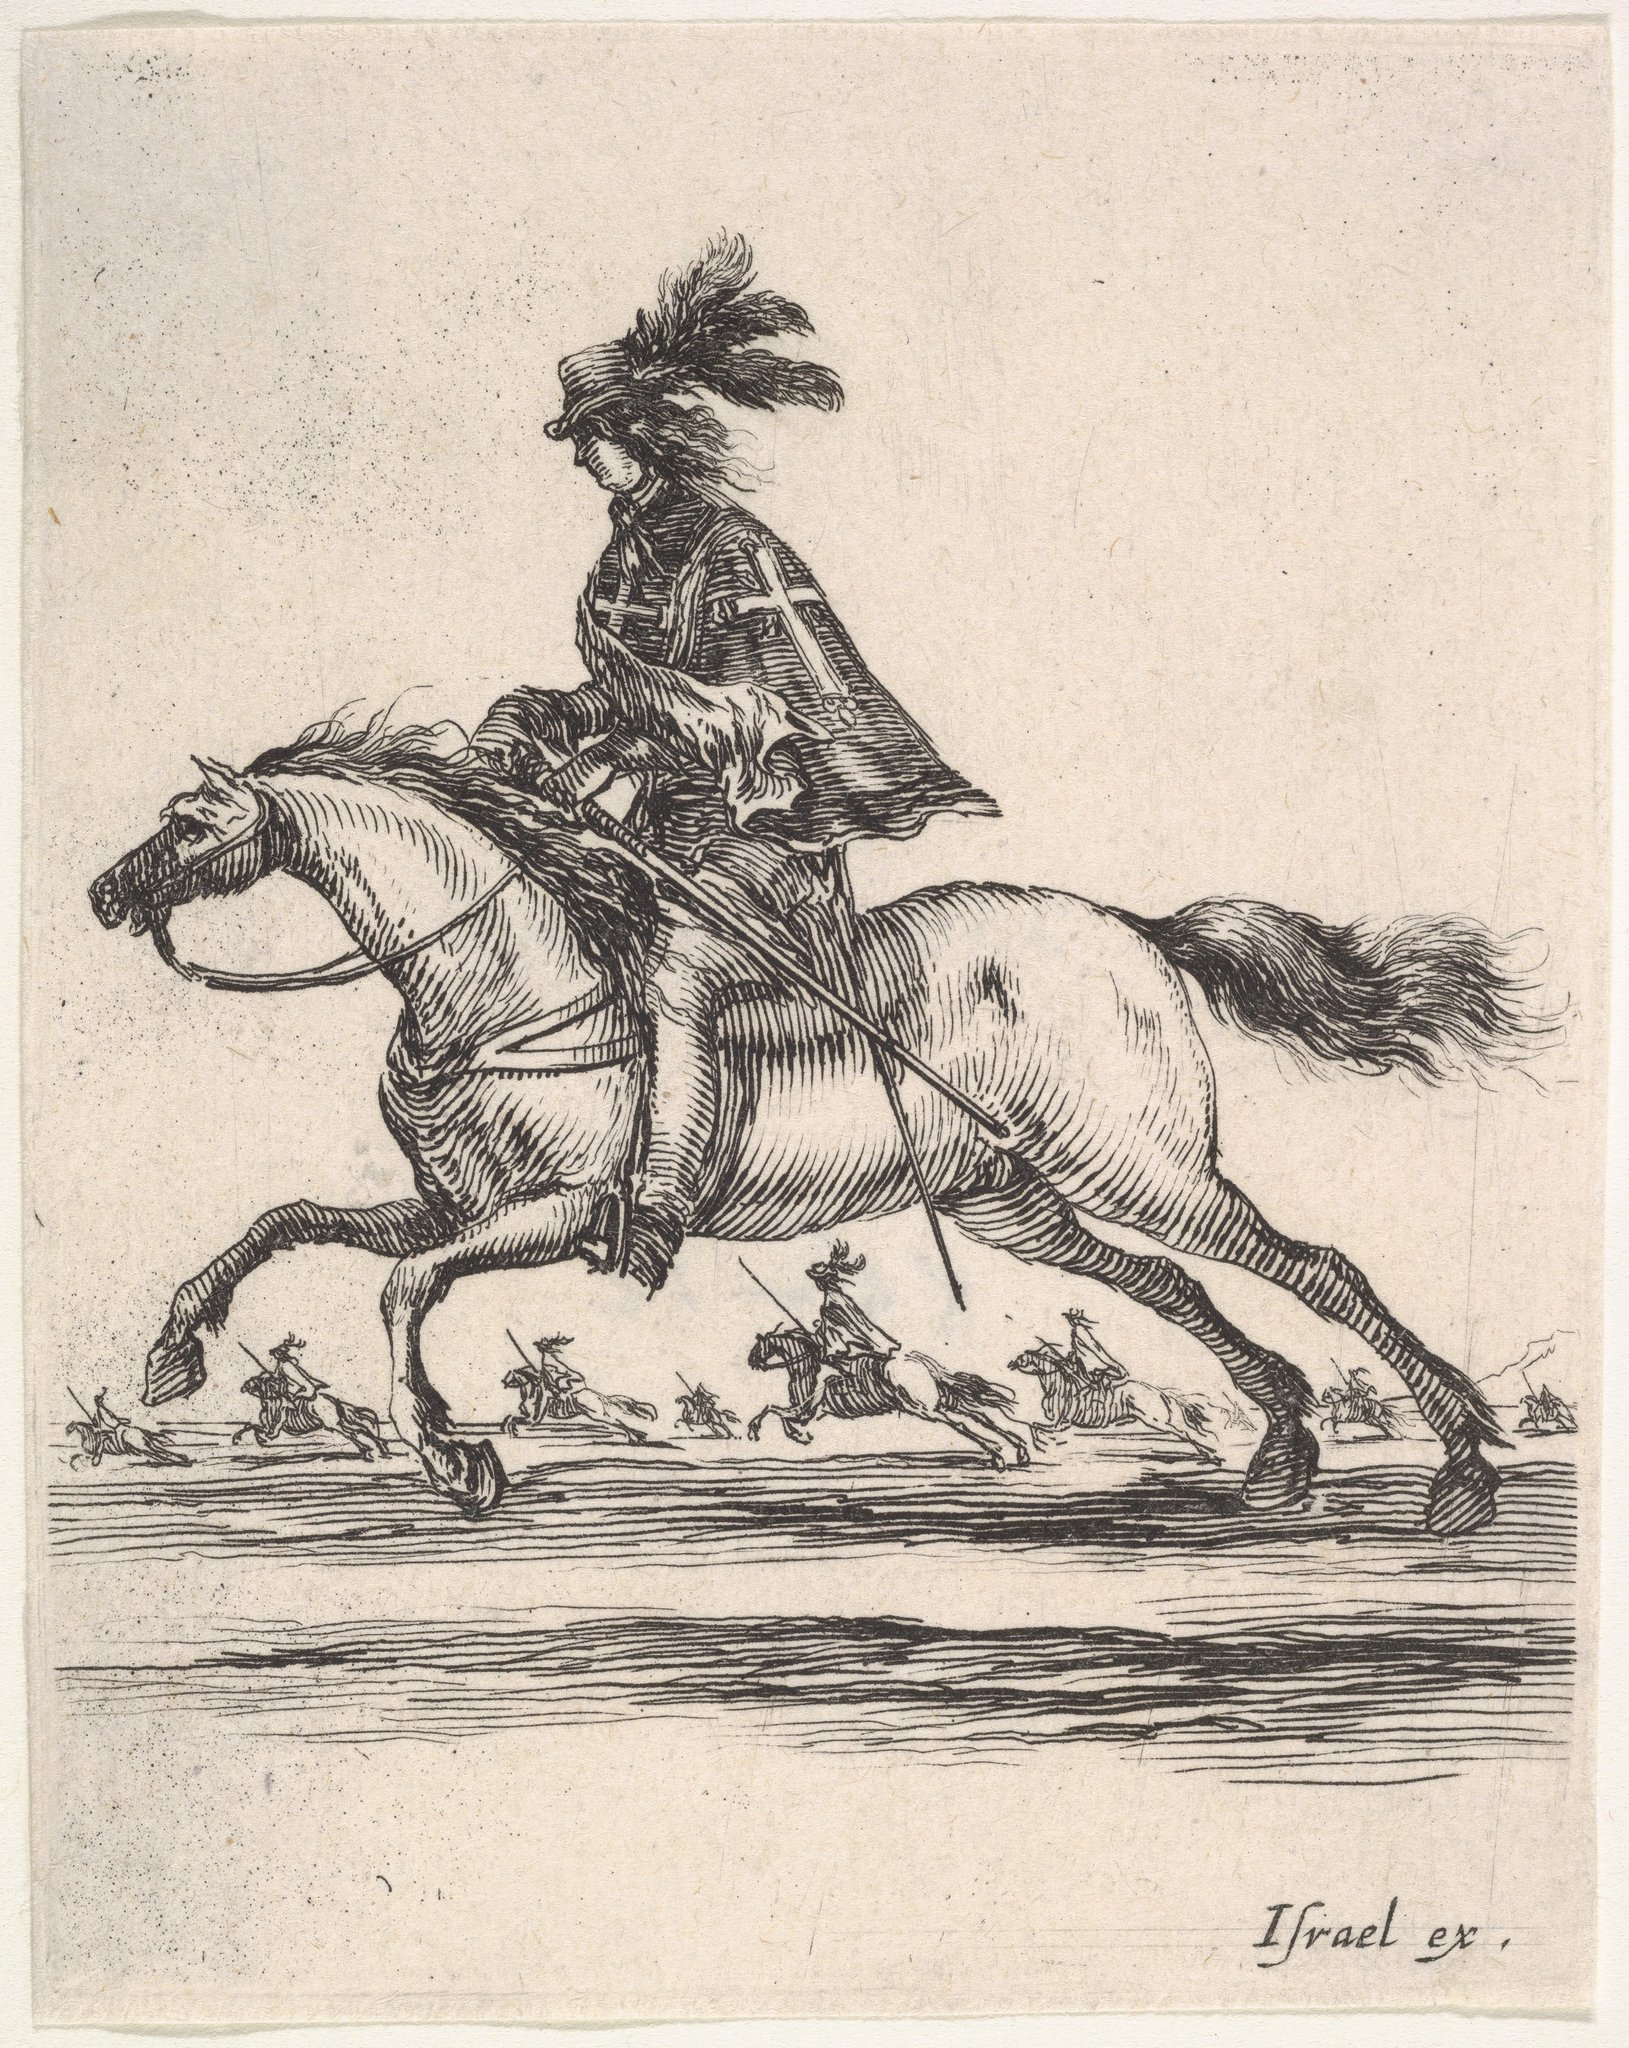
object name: print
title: A musketeer galloping towards the left, other horsemen galloping towards the left in background, from "Various cavalry exercises" (Diverses exercices de cavalerie)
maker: stefano della bella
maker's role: artist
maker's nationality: italian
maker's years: 1610-1664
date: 1642-1645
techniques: etching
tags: men,horses